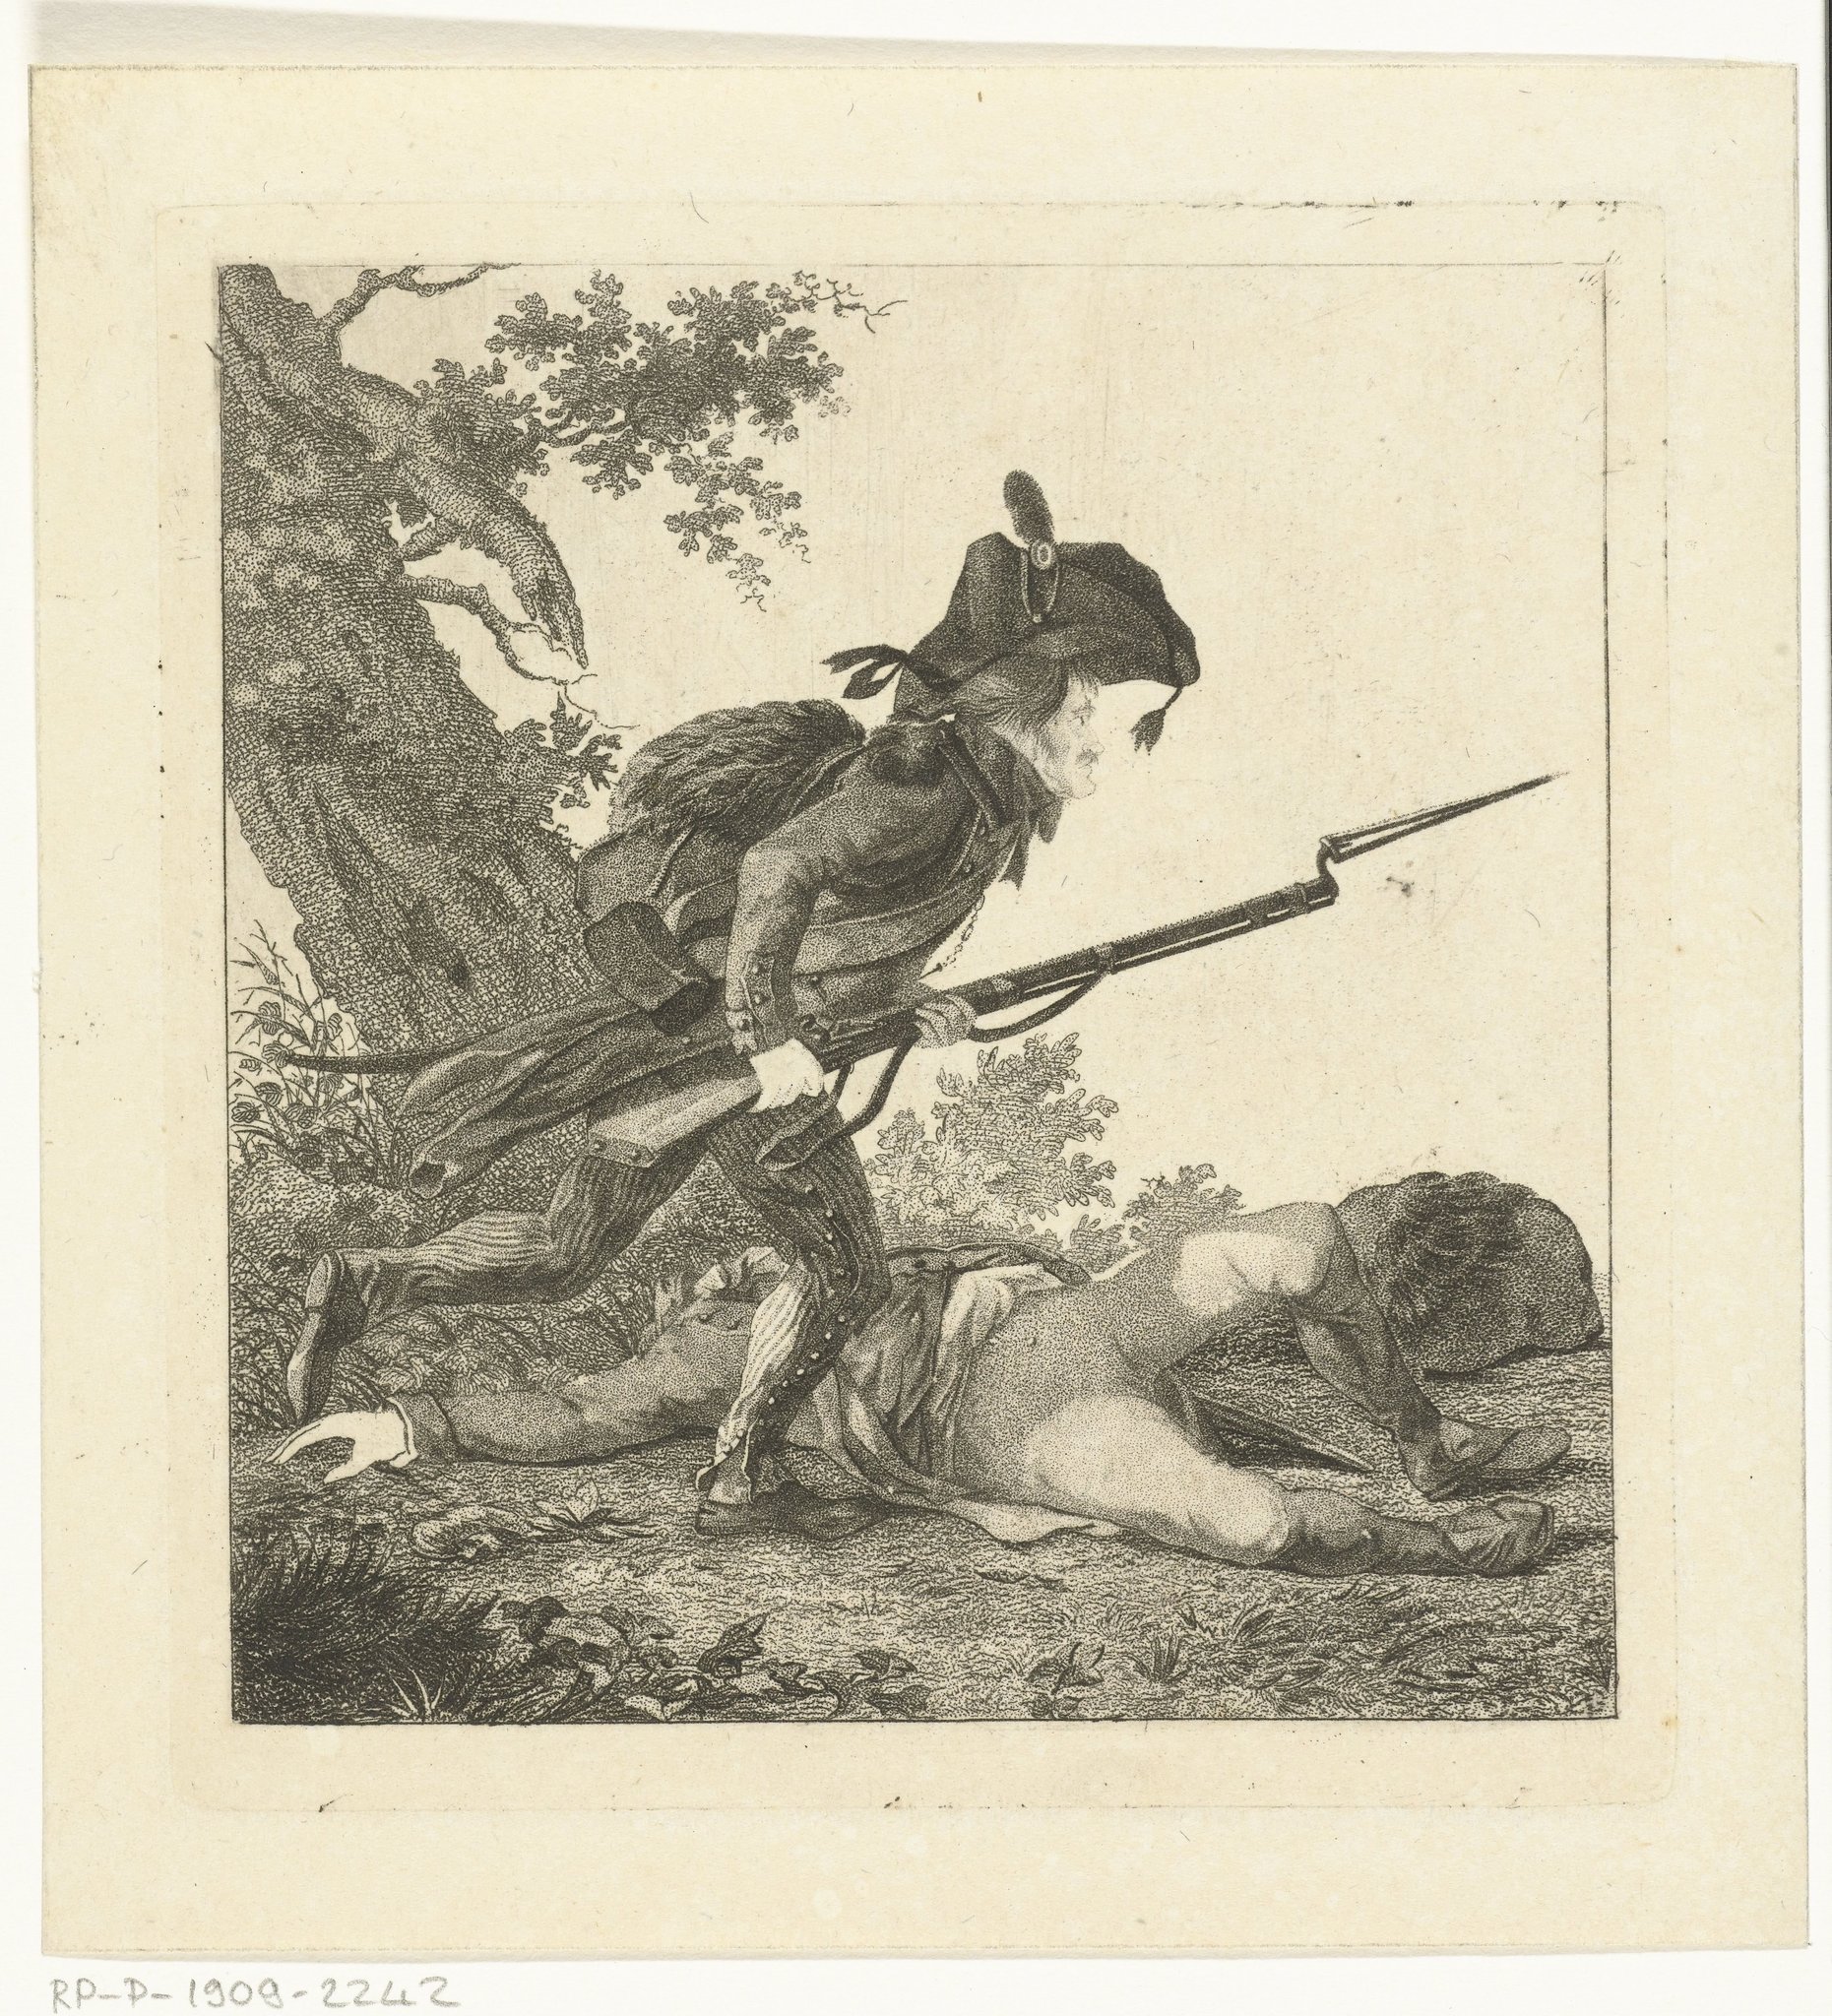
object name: print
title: Soldaat met geweer in de hand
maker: joannes bemme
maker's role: print maker, printer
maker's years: 1775-1841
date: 1800-1841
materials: paper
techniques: etching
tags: battle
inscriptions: collector's mark: Lugt 2228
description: Een soldaat rent met een geweer in zijn hand. Op de grond ligt een dode soldaat.